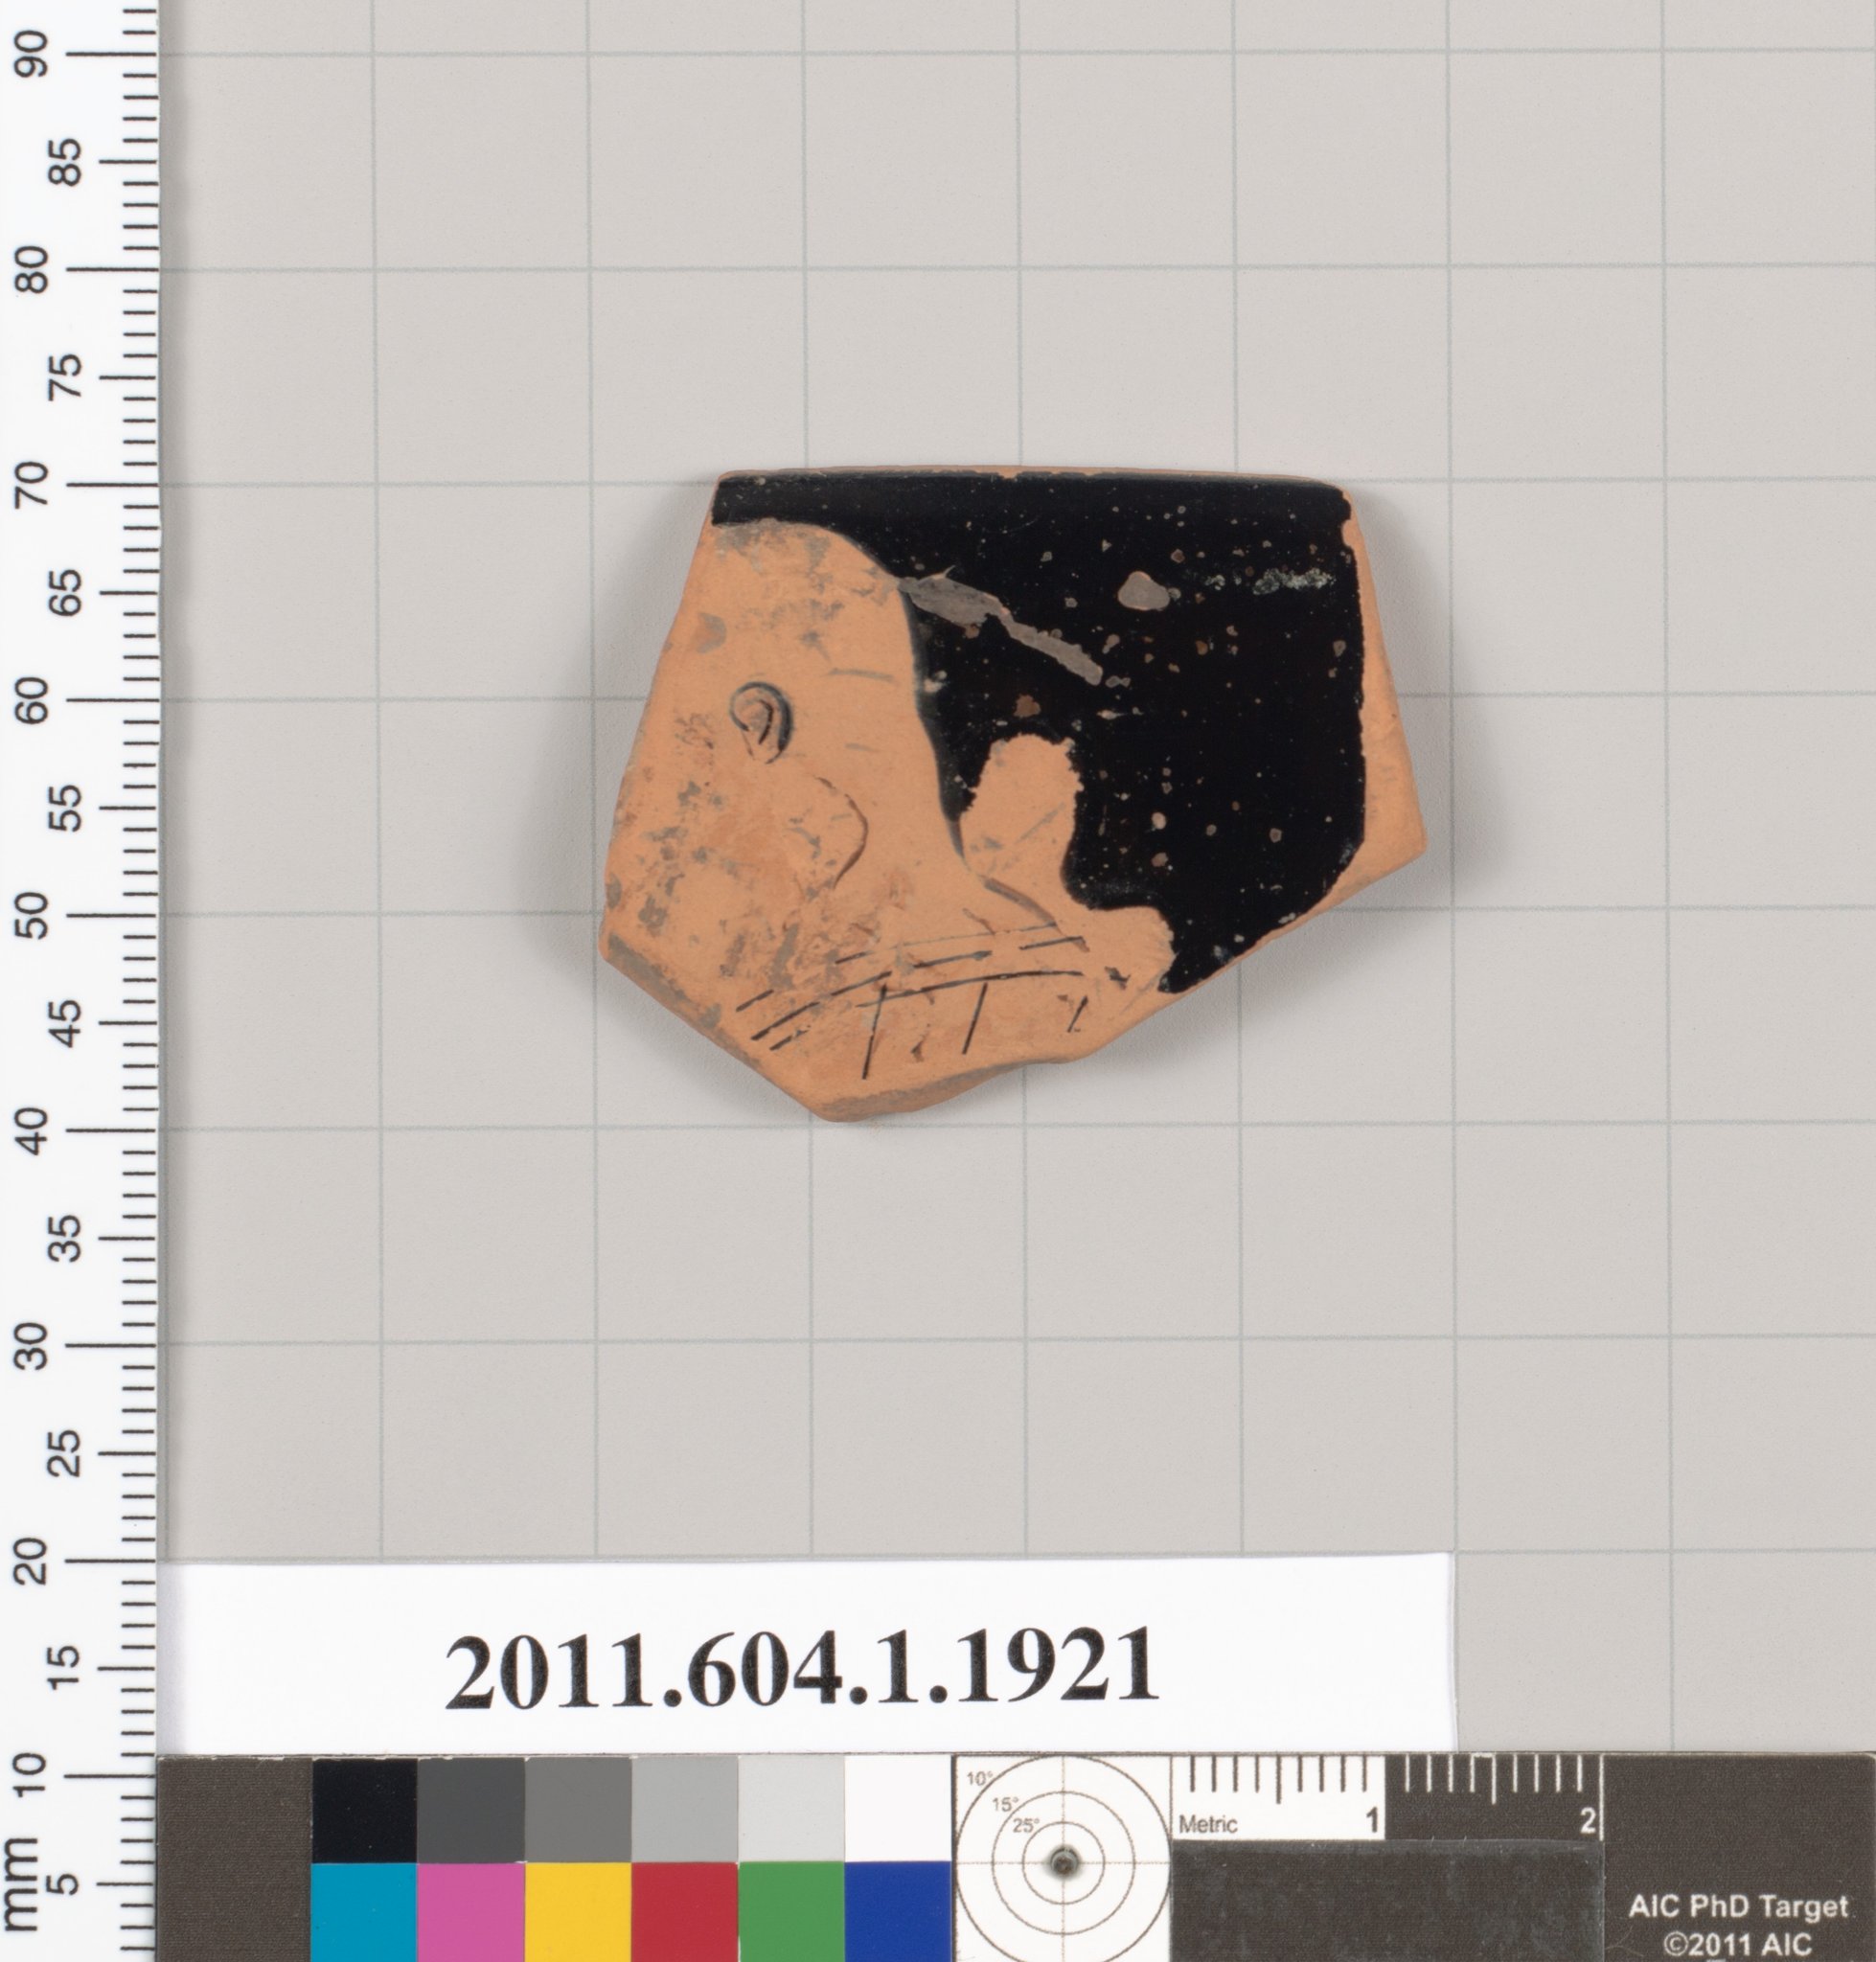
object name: kylix fragment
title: Terracotta rim fragment of a kylix (drinking cup)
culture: greek, attic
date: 475-451 BCE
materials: terracotta